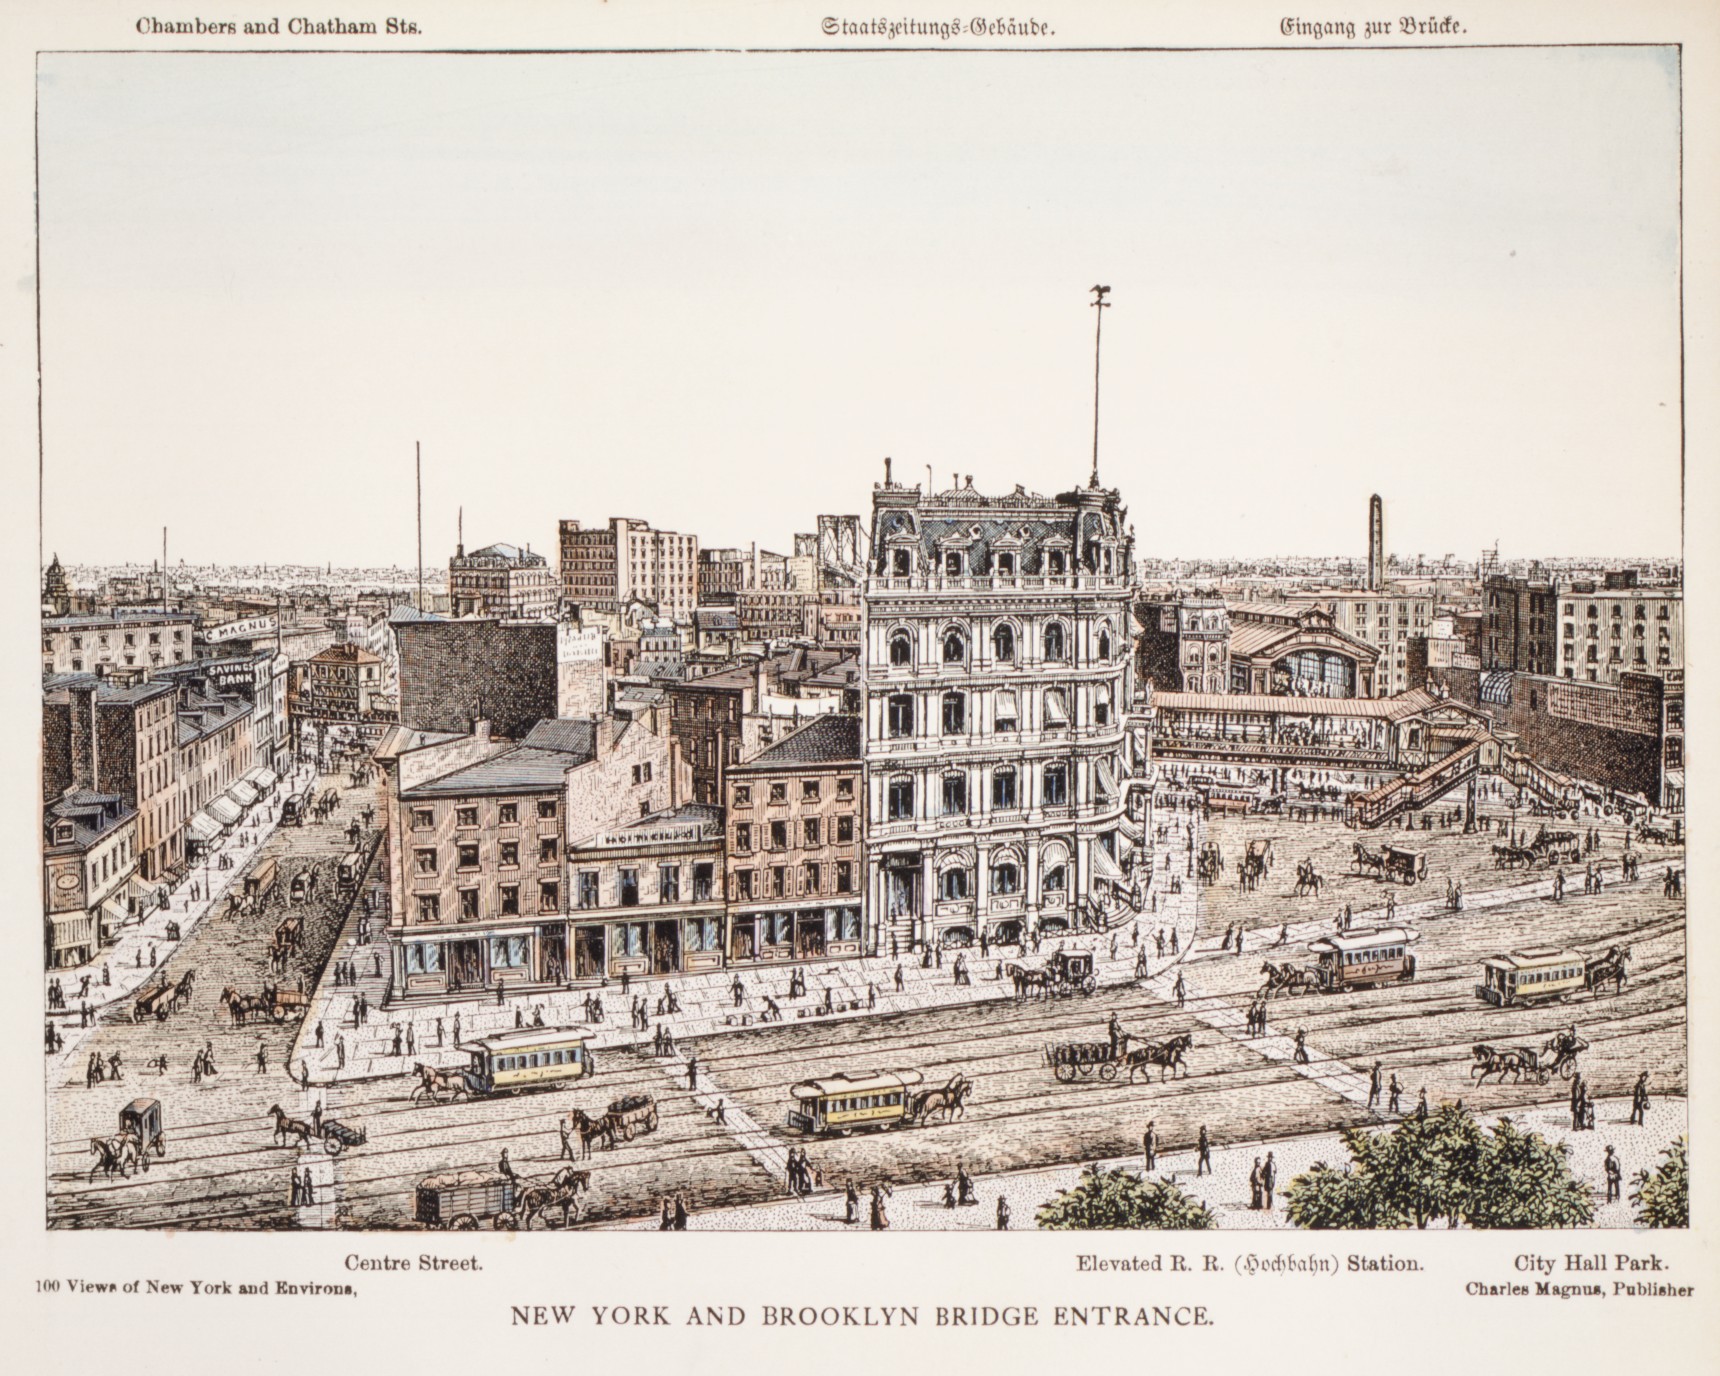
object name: print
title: New York and Brooklyn Bridge Entrance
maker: charles magnus & company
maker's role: publisher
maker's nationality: american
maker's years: 1854-1880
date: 1885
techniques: hand coloring, engraving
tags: cities,streets,carriages,new york city